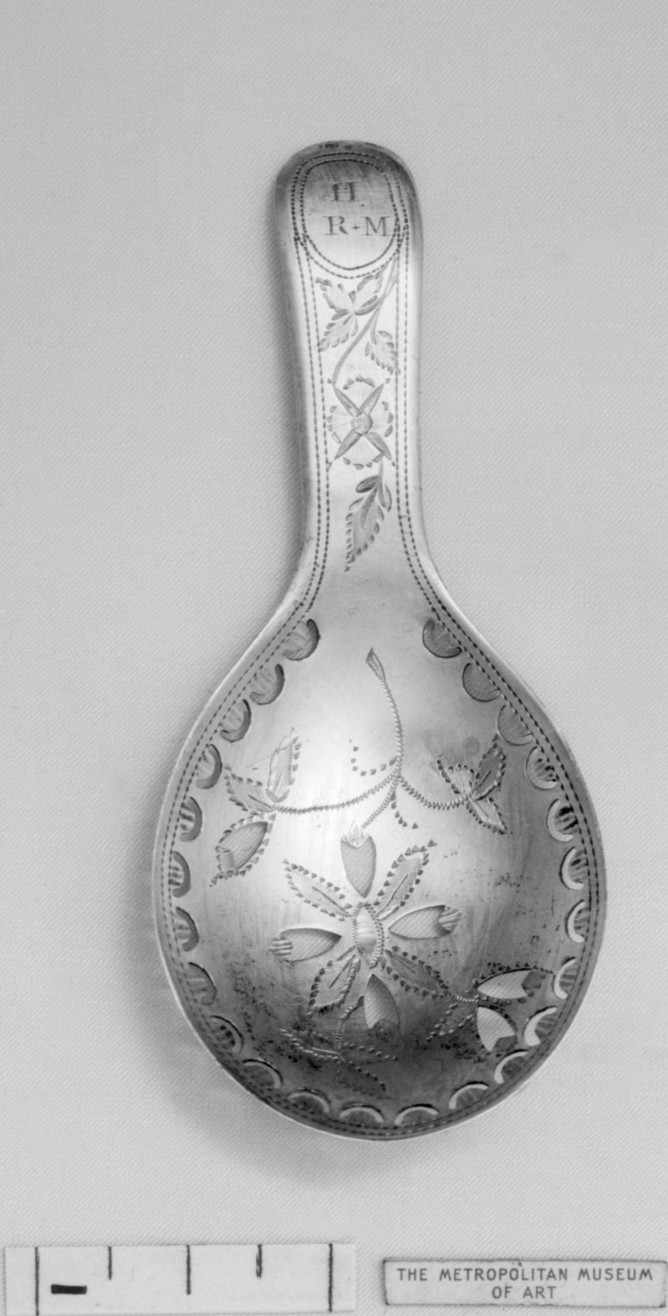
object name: caddy spoon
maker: samuel pemberton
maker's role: maker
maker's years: 1750-1850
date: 1803-1804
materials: silver